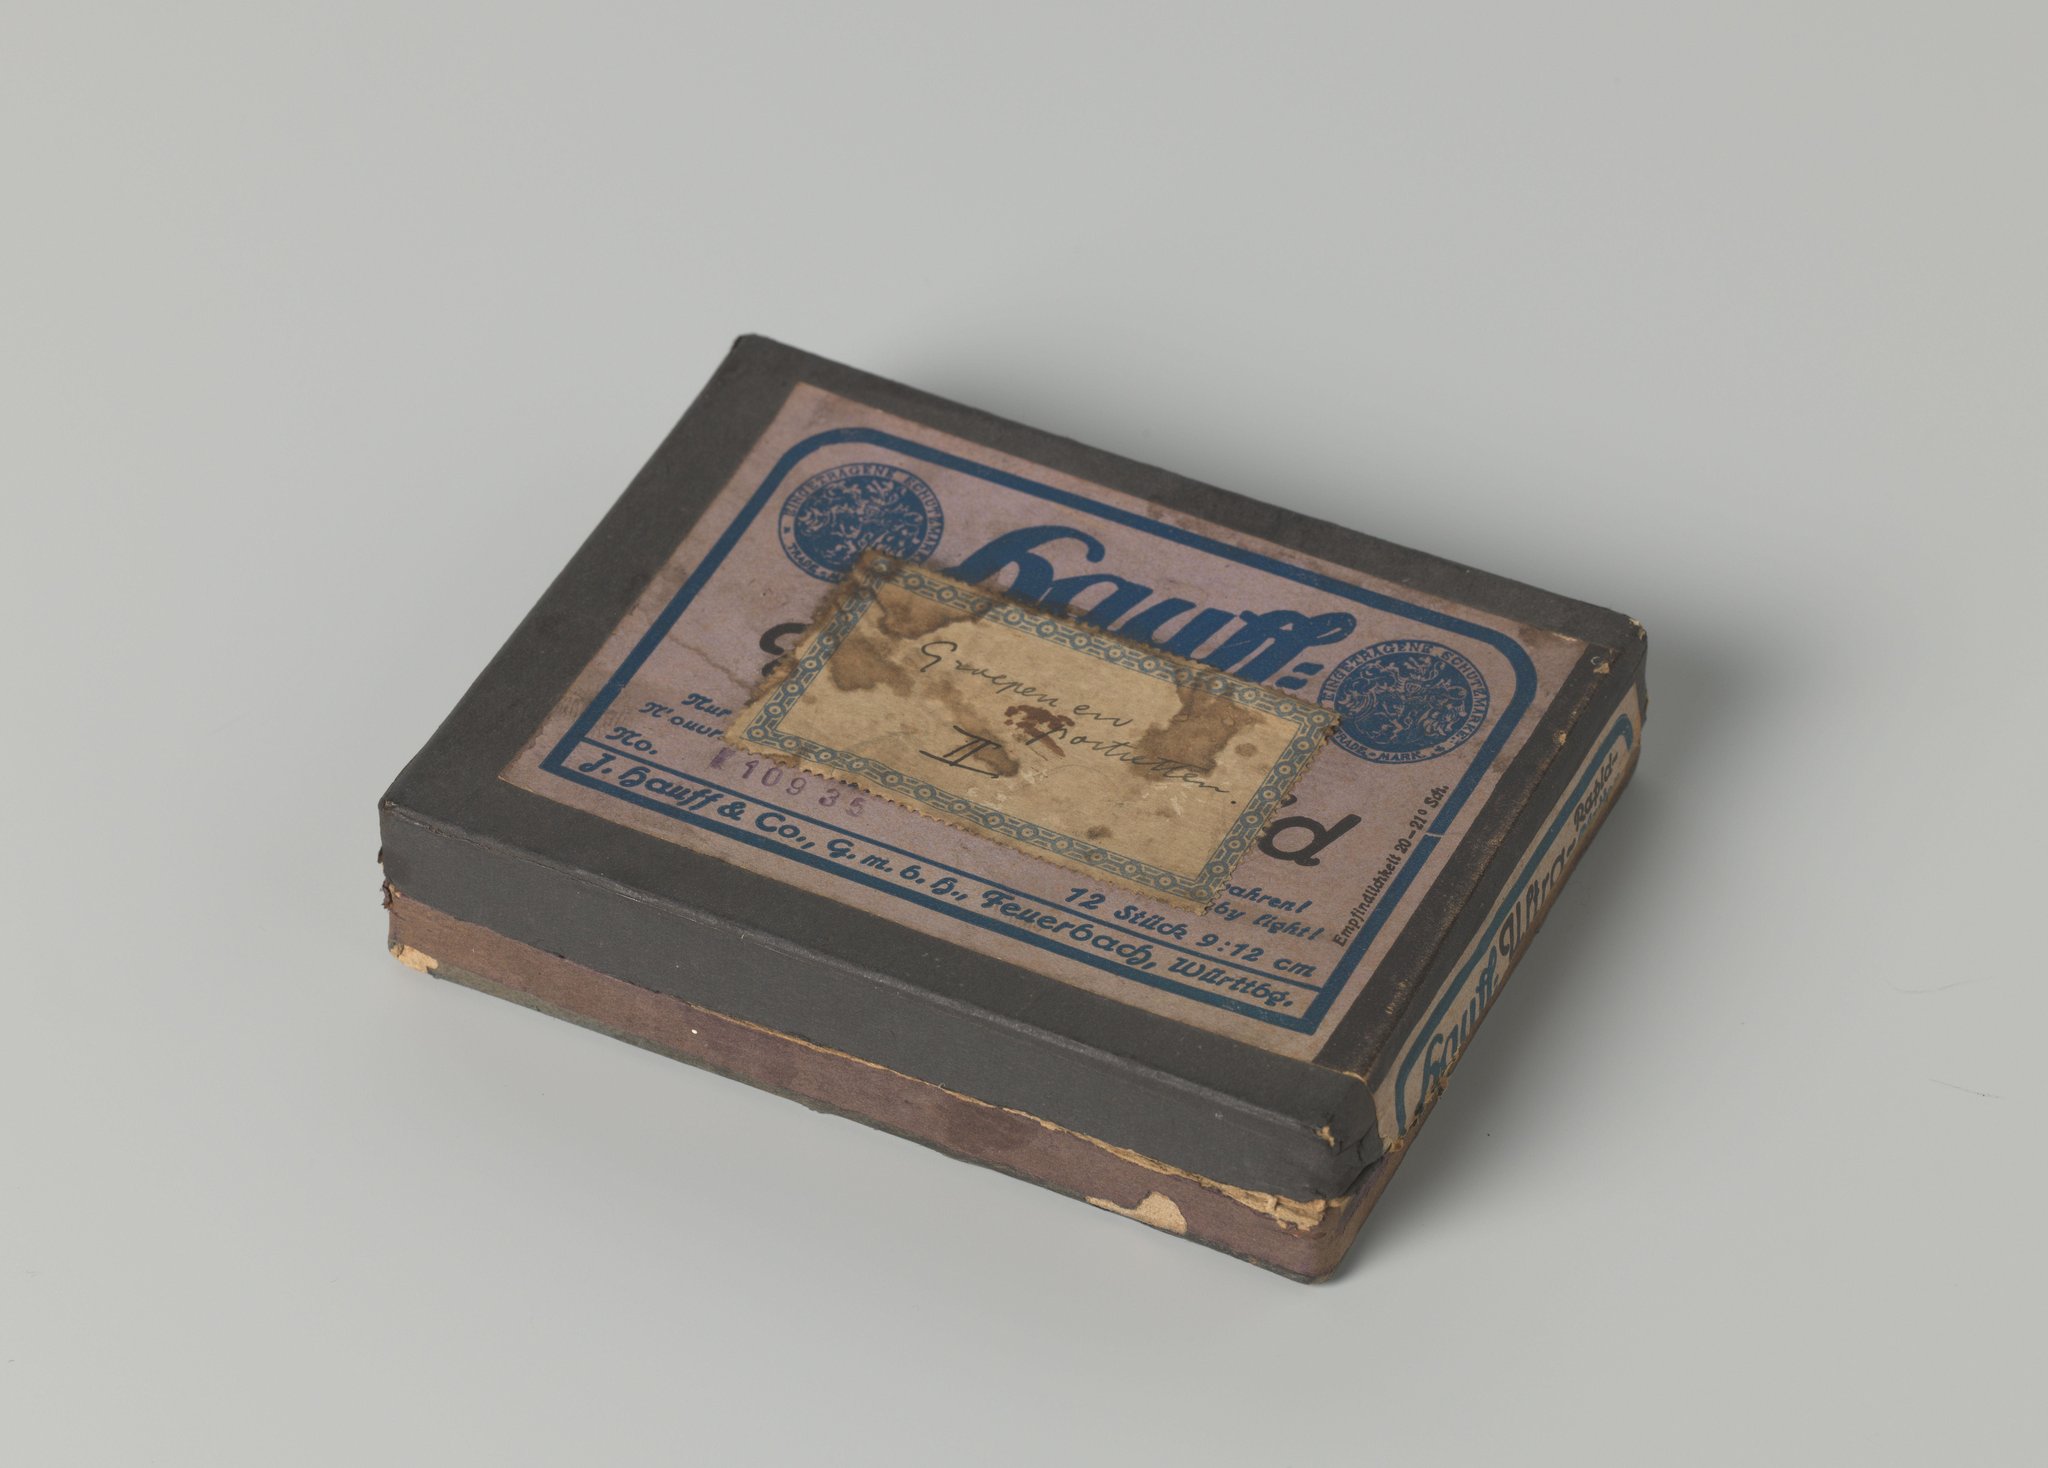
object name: box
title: Doos van J. Hauff & Co. voor glasnegatieven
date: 1900-1910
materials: cardboard, paper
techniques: printing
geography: stuttgart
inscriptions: inscription: ‘Groepen en/ portretten/ II’